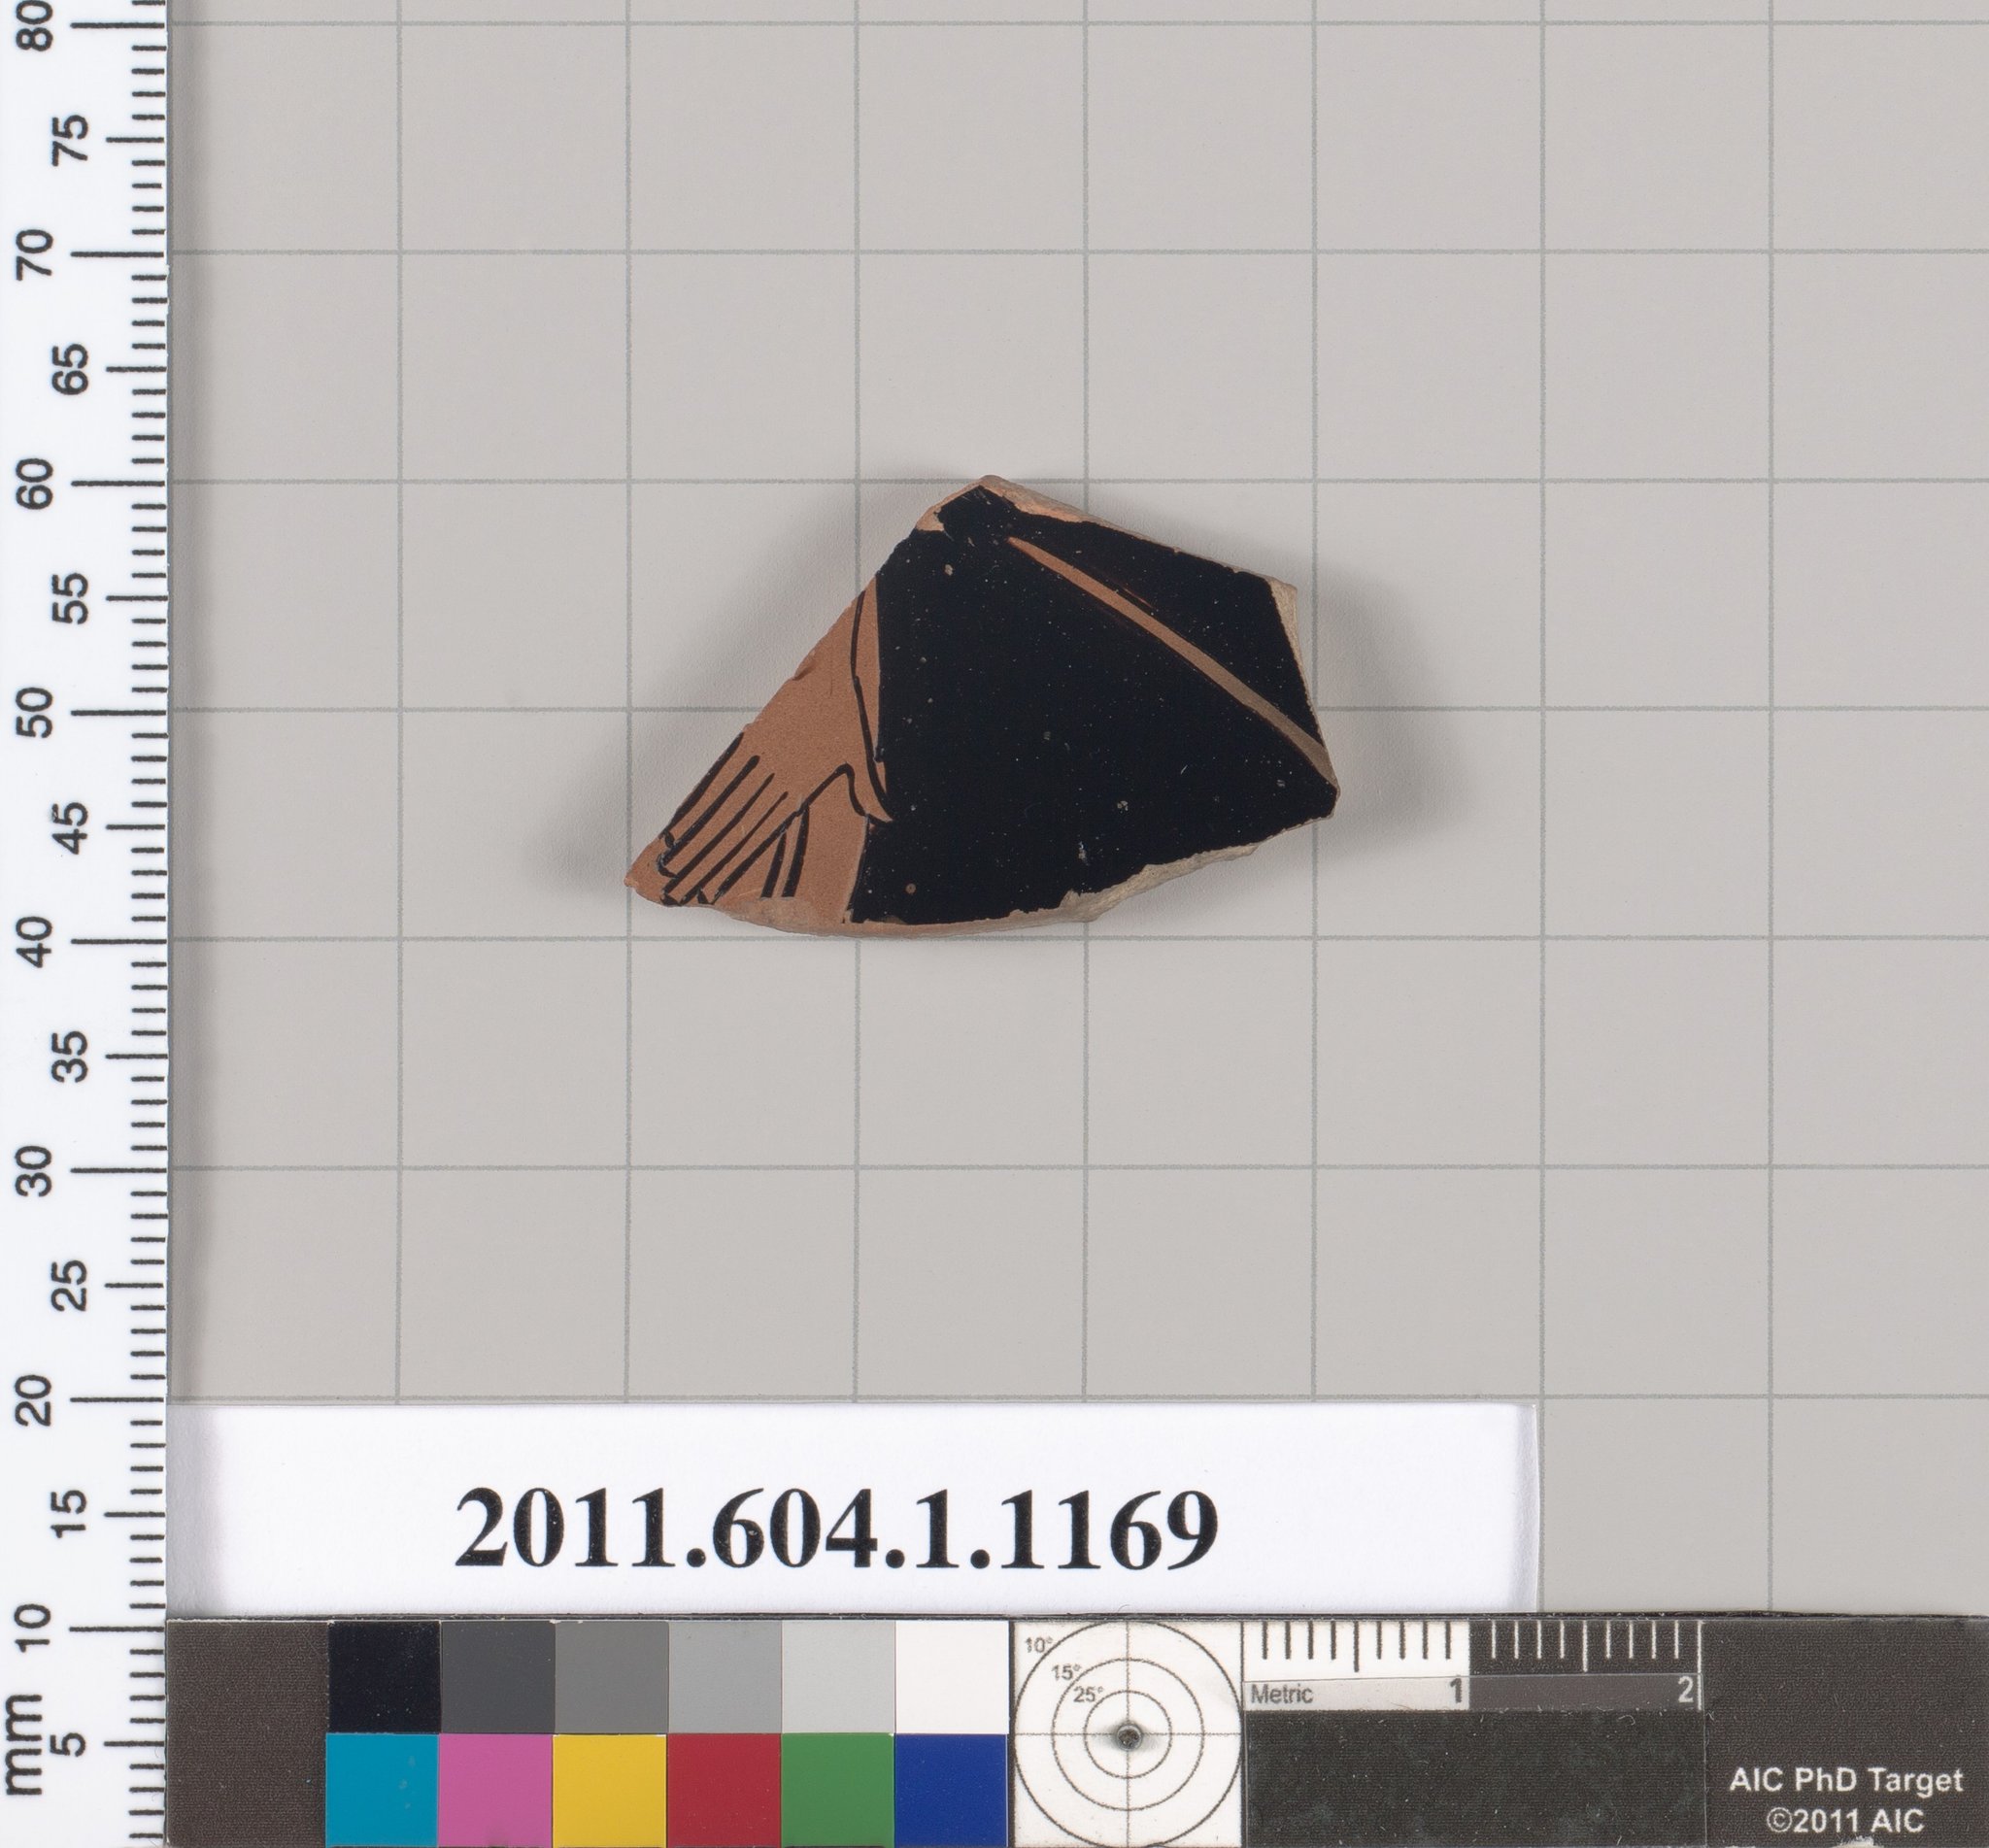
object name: kylix fragment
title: Terracotta fragment of a kylix (drinking cup)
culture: greek, attic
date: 490-480 BCE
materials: terracotta